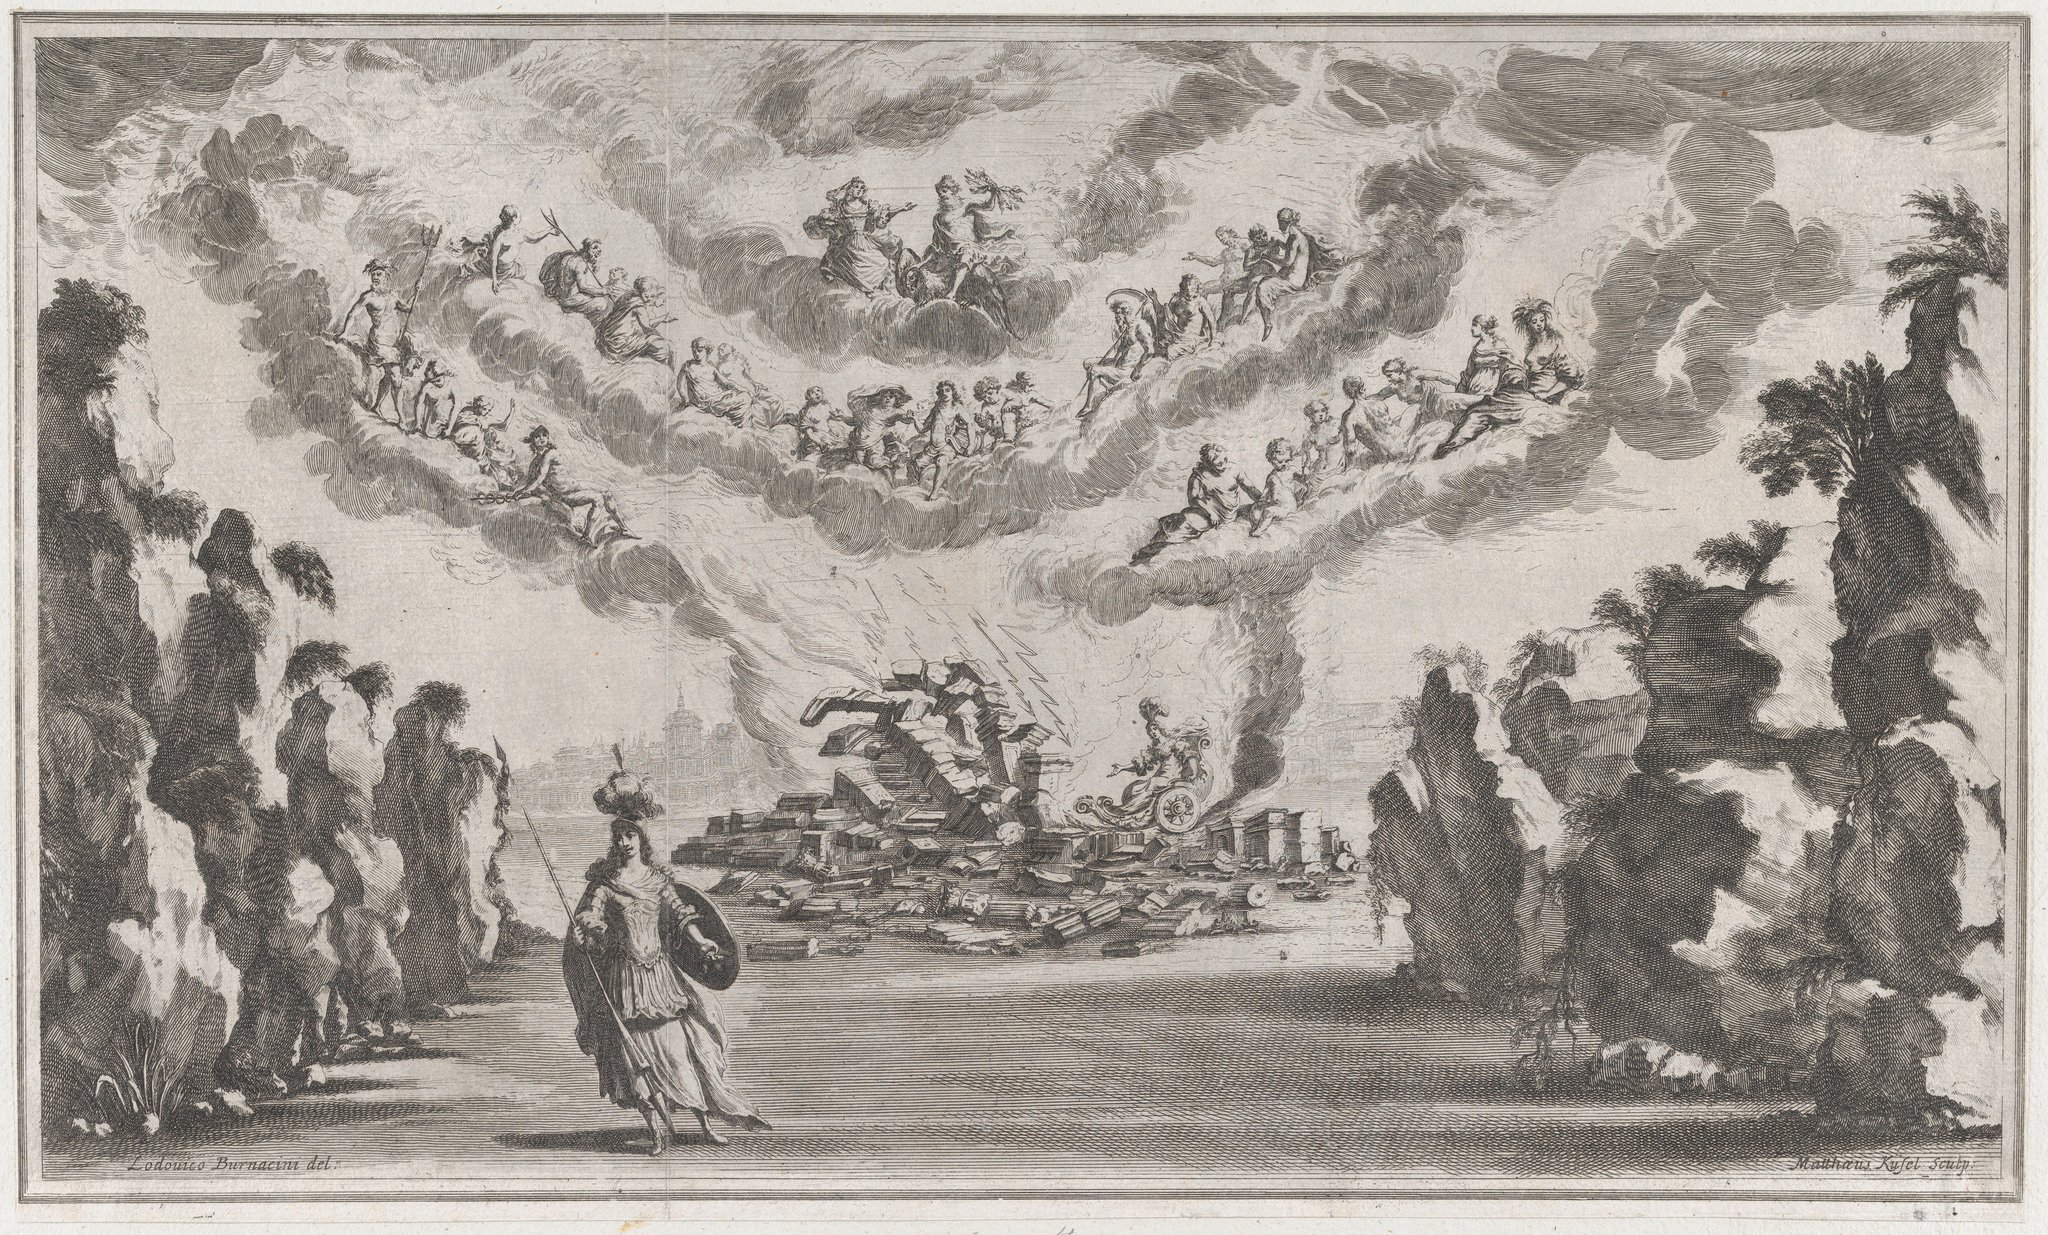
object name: print, fete, ornament architecture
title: A woman in a chariot arrives at the ruins of a building as the Olympian gods look down from above, in the foreground stands an armed female figure; set design from 'Il Pomo D'Oro'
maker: mathäus küsel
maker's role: artist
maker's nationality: german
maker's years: 1621-1682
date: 1668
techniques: engraving, etching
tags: opera,ruins,women,chariots